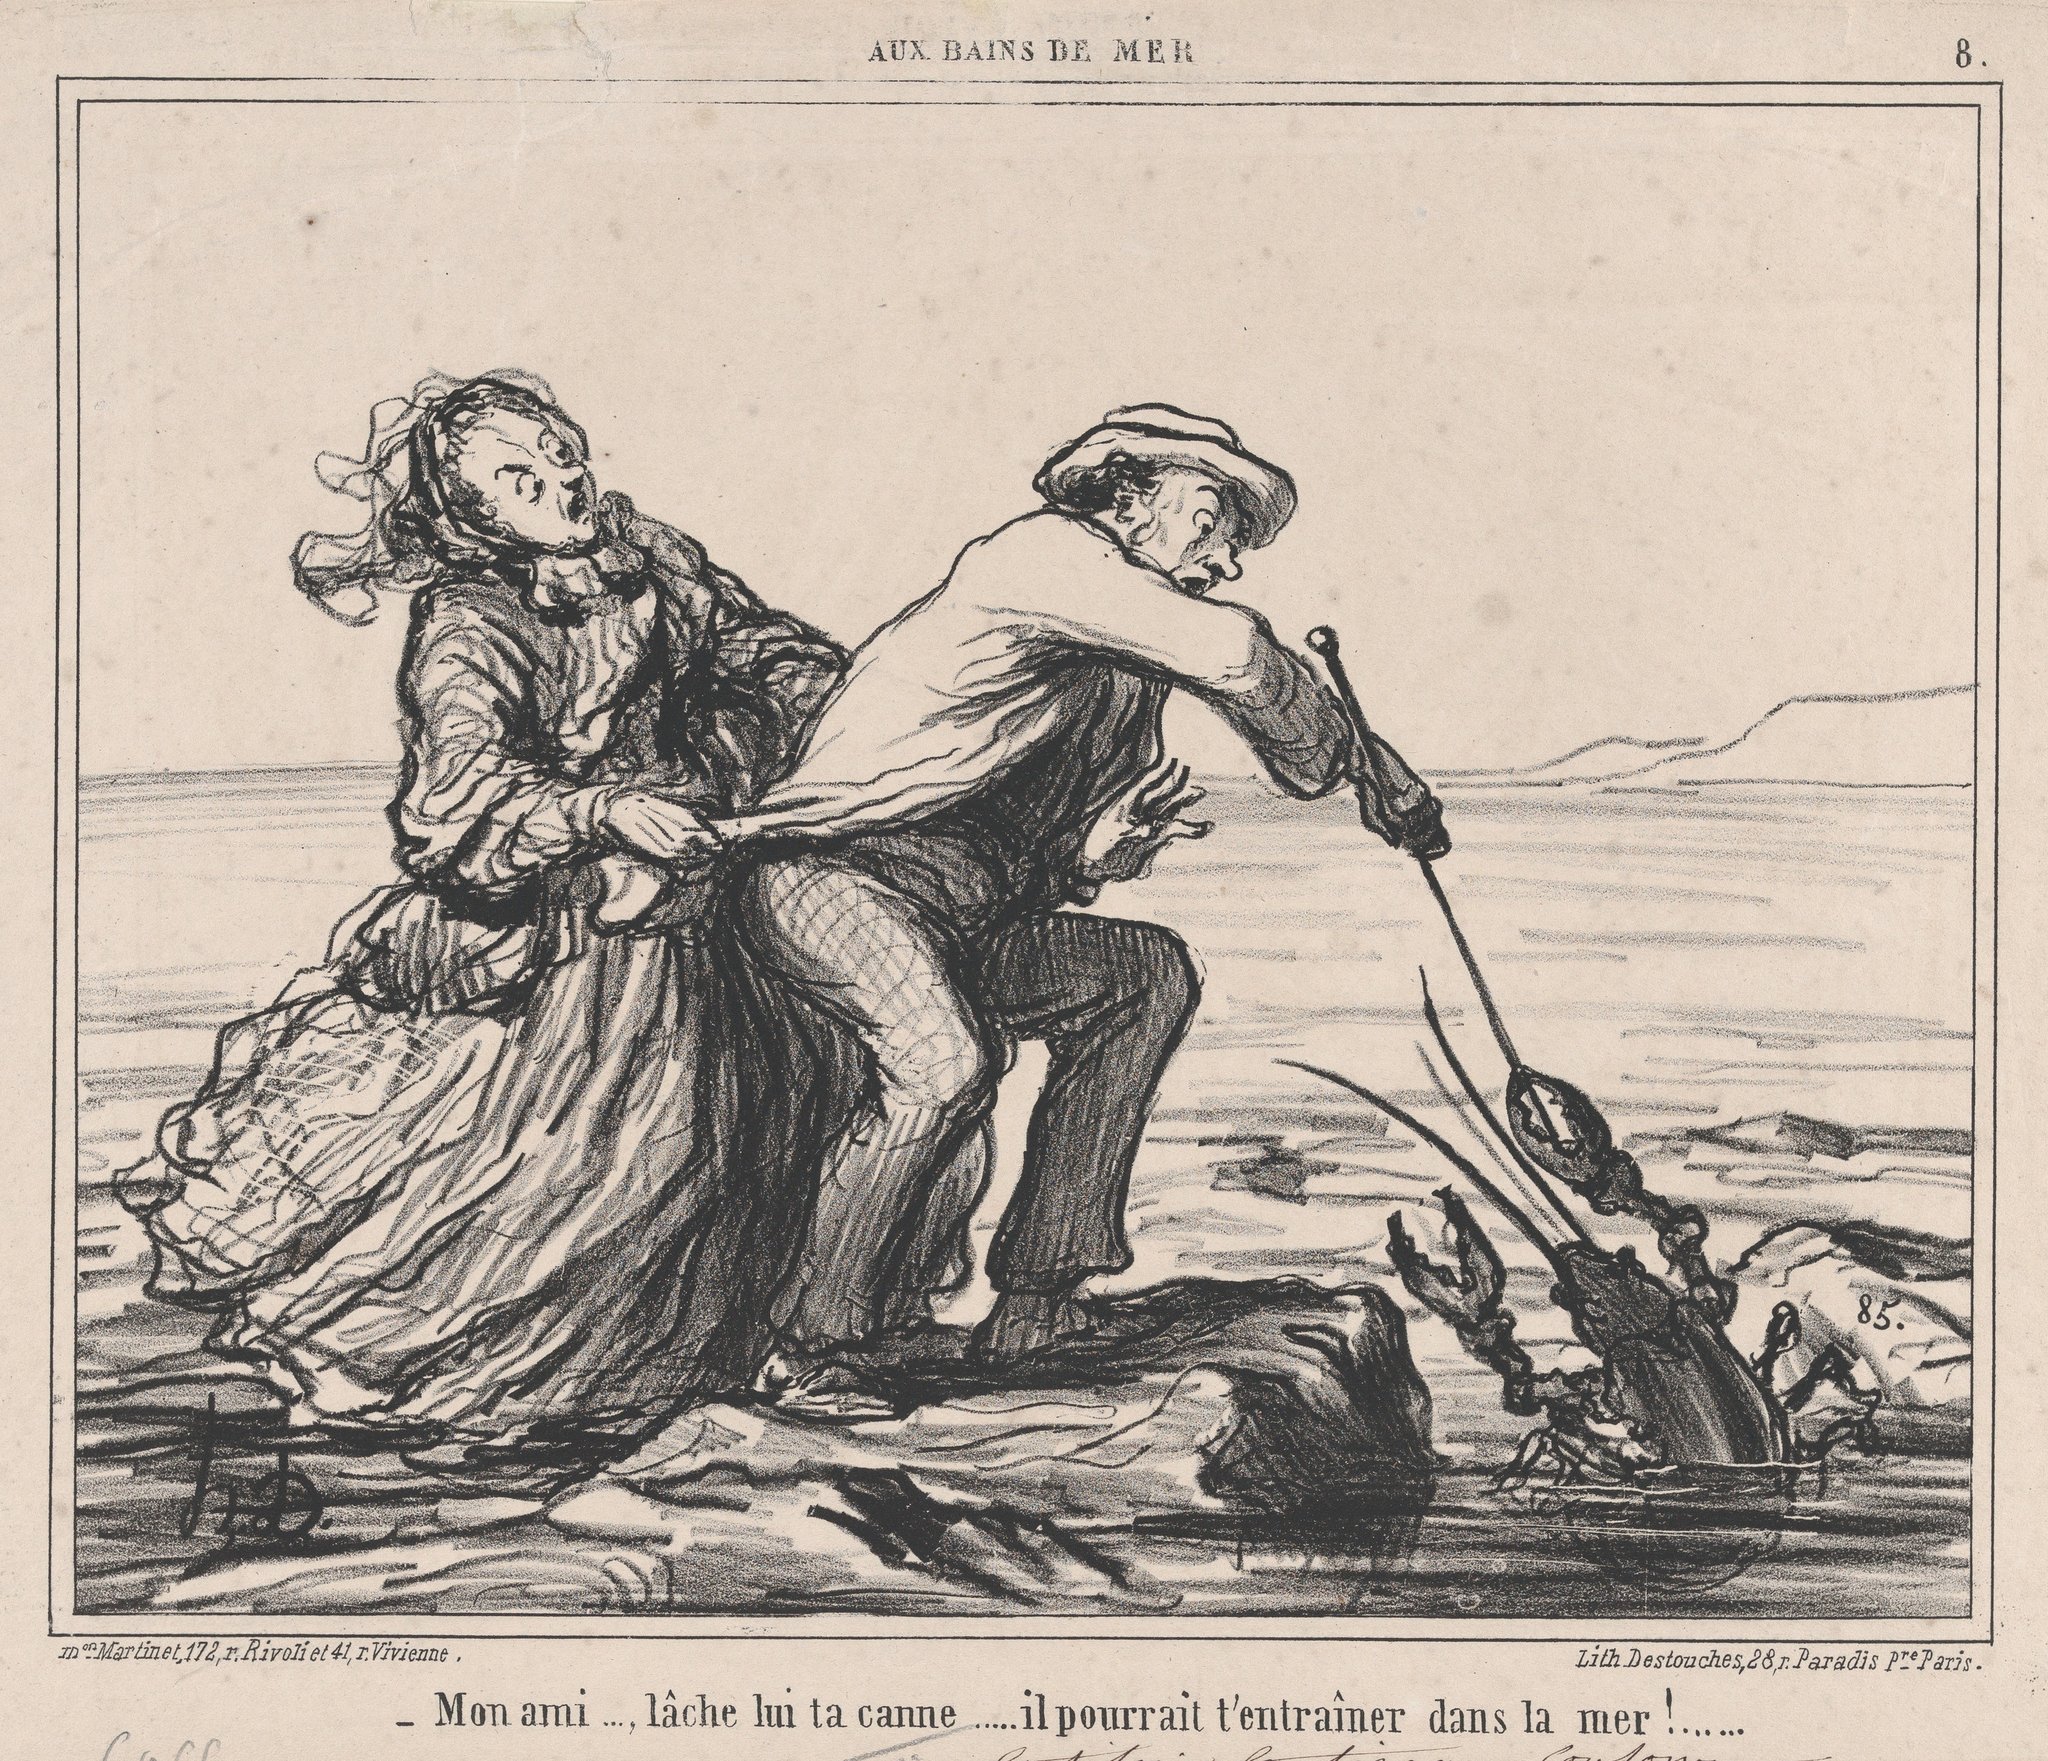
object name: print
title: Mon ami..., lâche lui ta canne.... from Aux Bains de Mer, published in Le Charivari, September 28, 1859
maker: honoré daumier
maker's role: artist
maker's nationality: french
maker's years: 1808-1879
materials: paper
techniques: lithograph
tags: animals,men,women